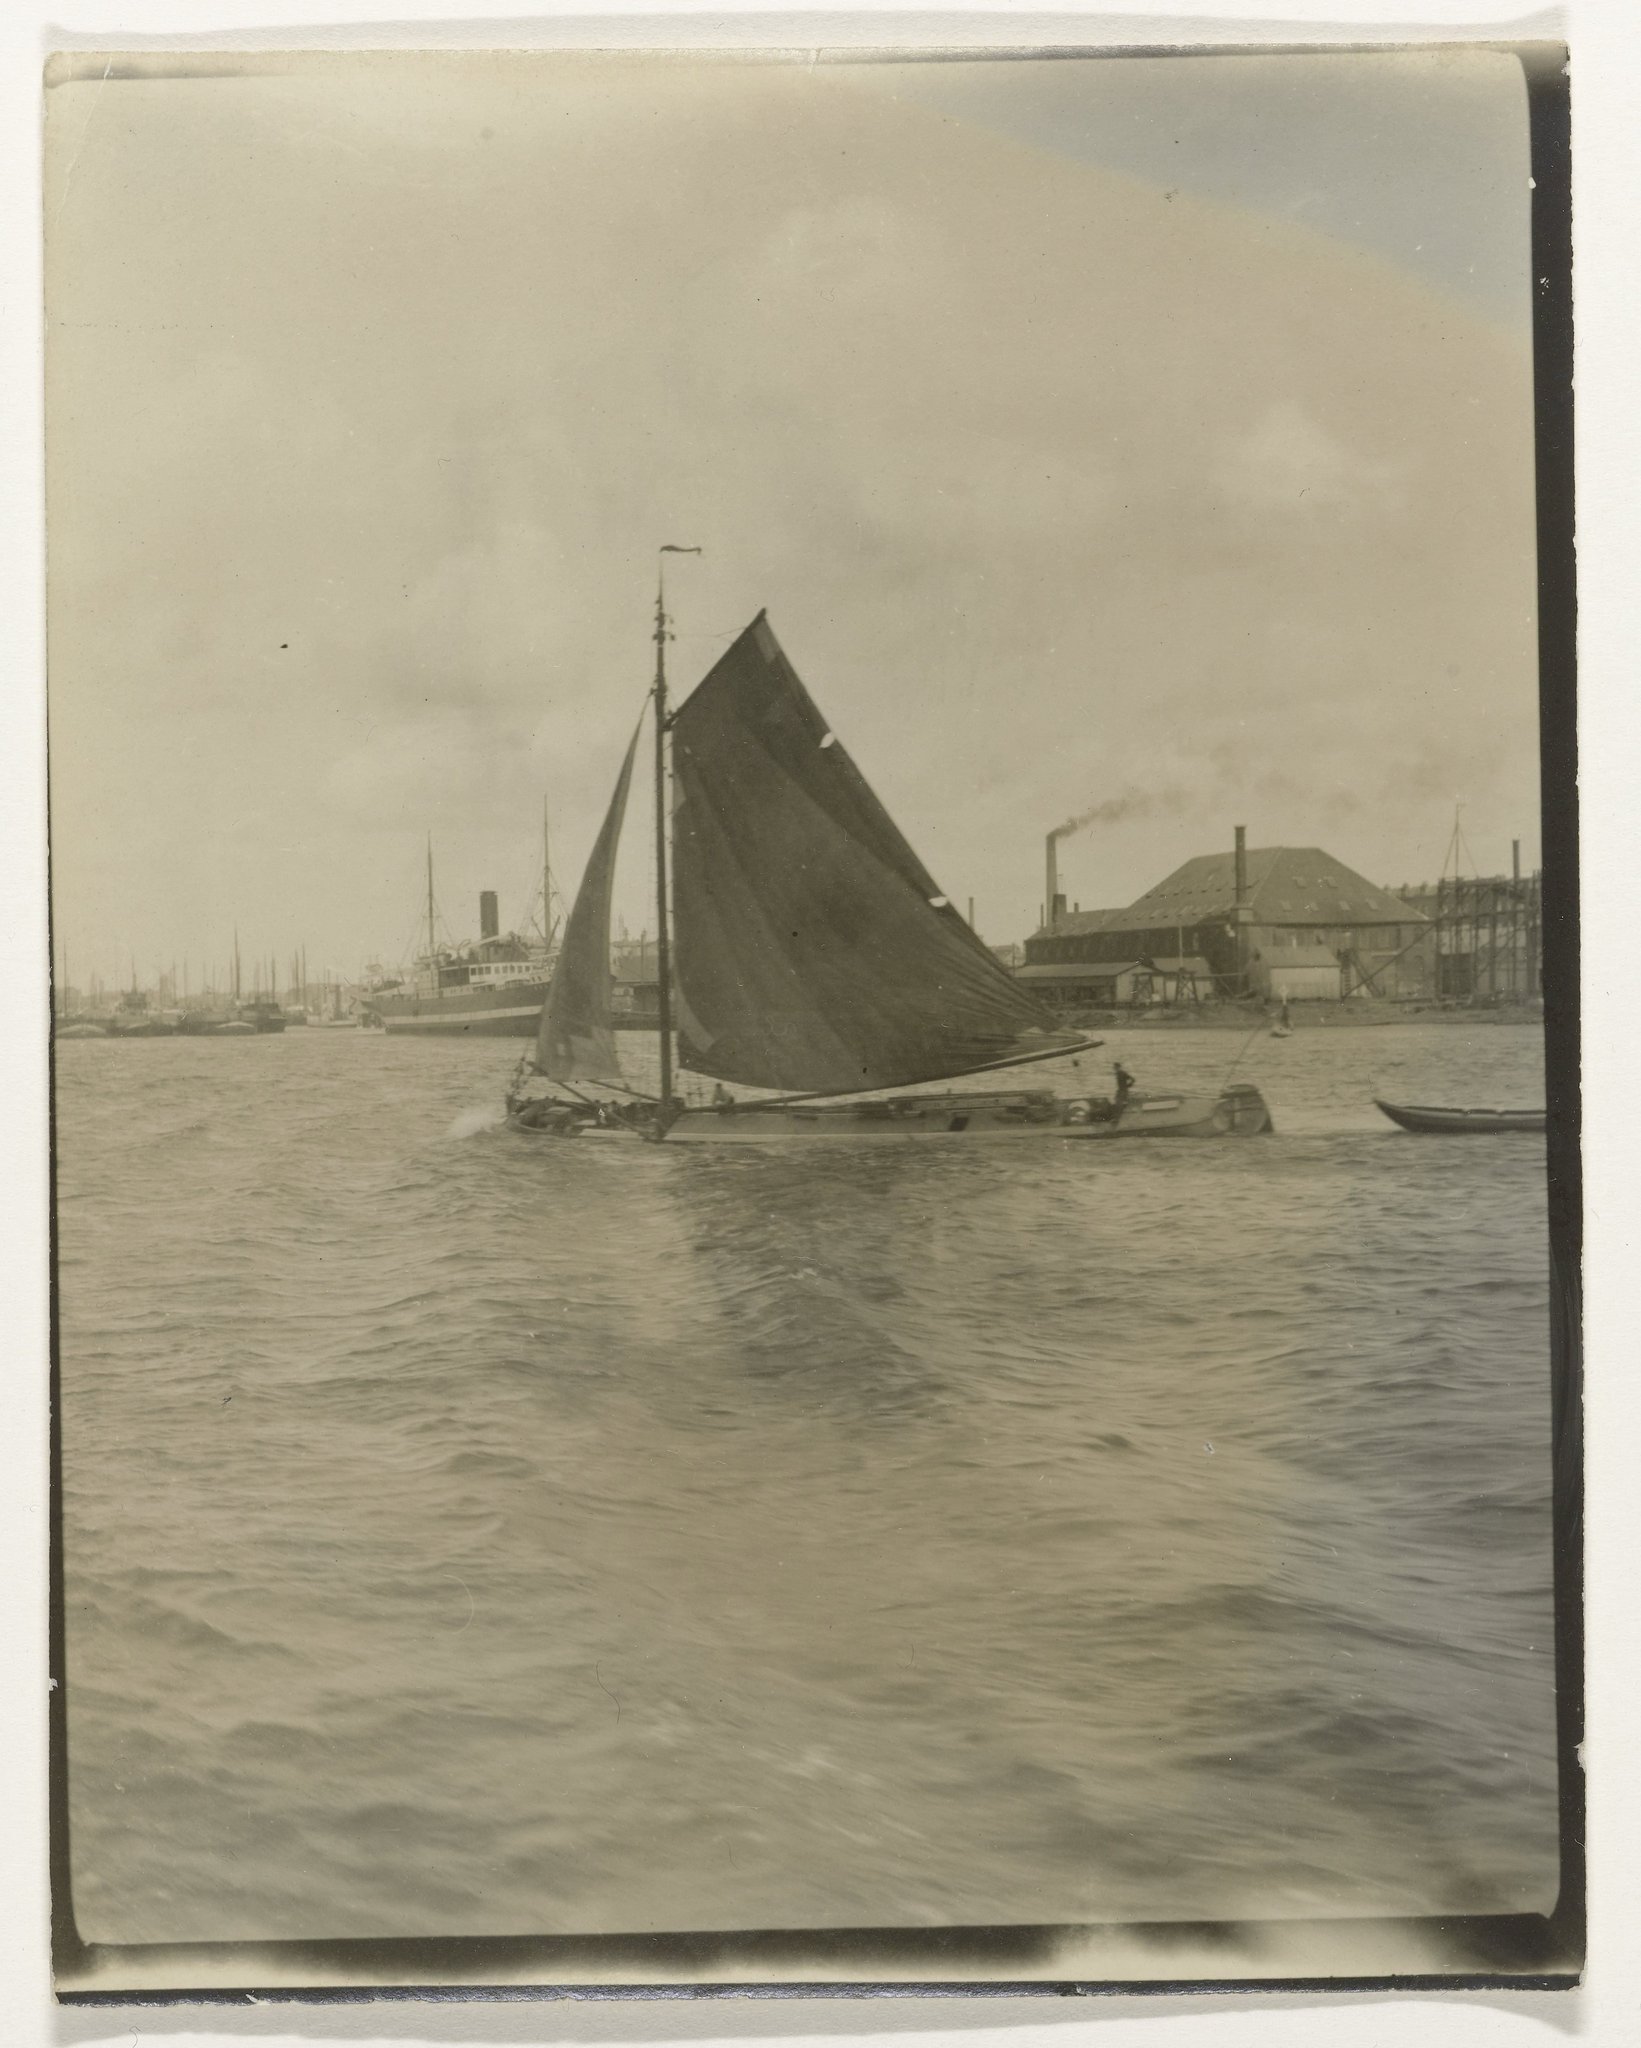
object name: photograph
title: Gezicht over een rivier of kanaal, Nederland, met een zeilschip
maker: Anonymous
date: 1900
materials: paper, photographic support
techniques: gelatin silver print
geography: netherlands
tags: sailing-ship, sailing-boat, factory in landscape, river (+ landscape with figures, staffage), netherlands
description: Gezicht over een rivier of kanaal, Nederland, met een zeilschip en op de achtergrond een fabriek, een stoomschip en een haven.